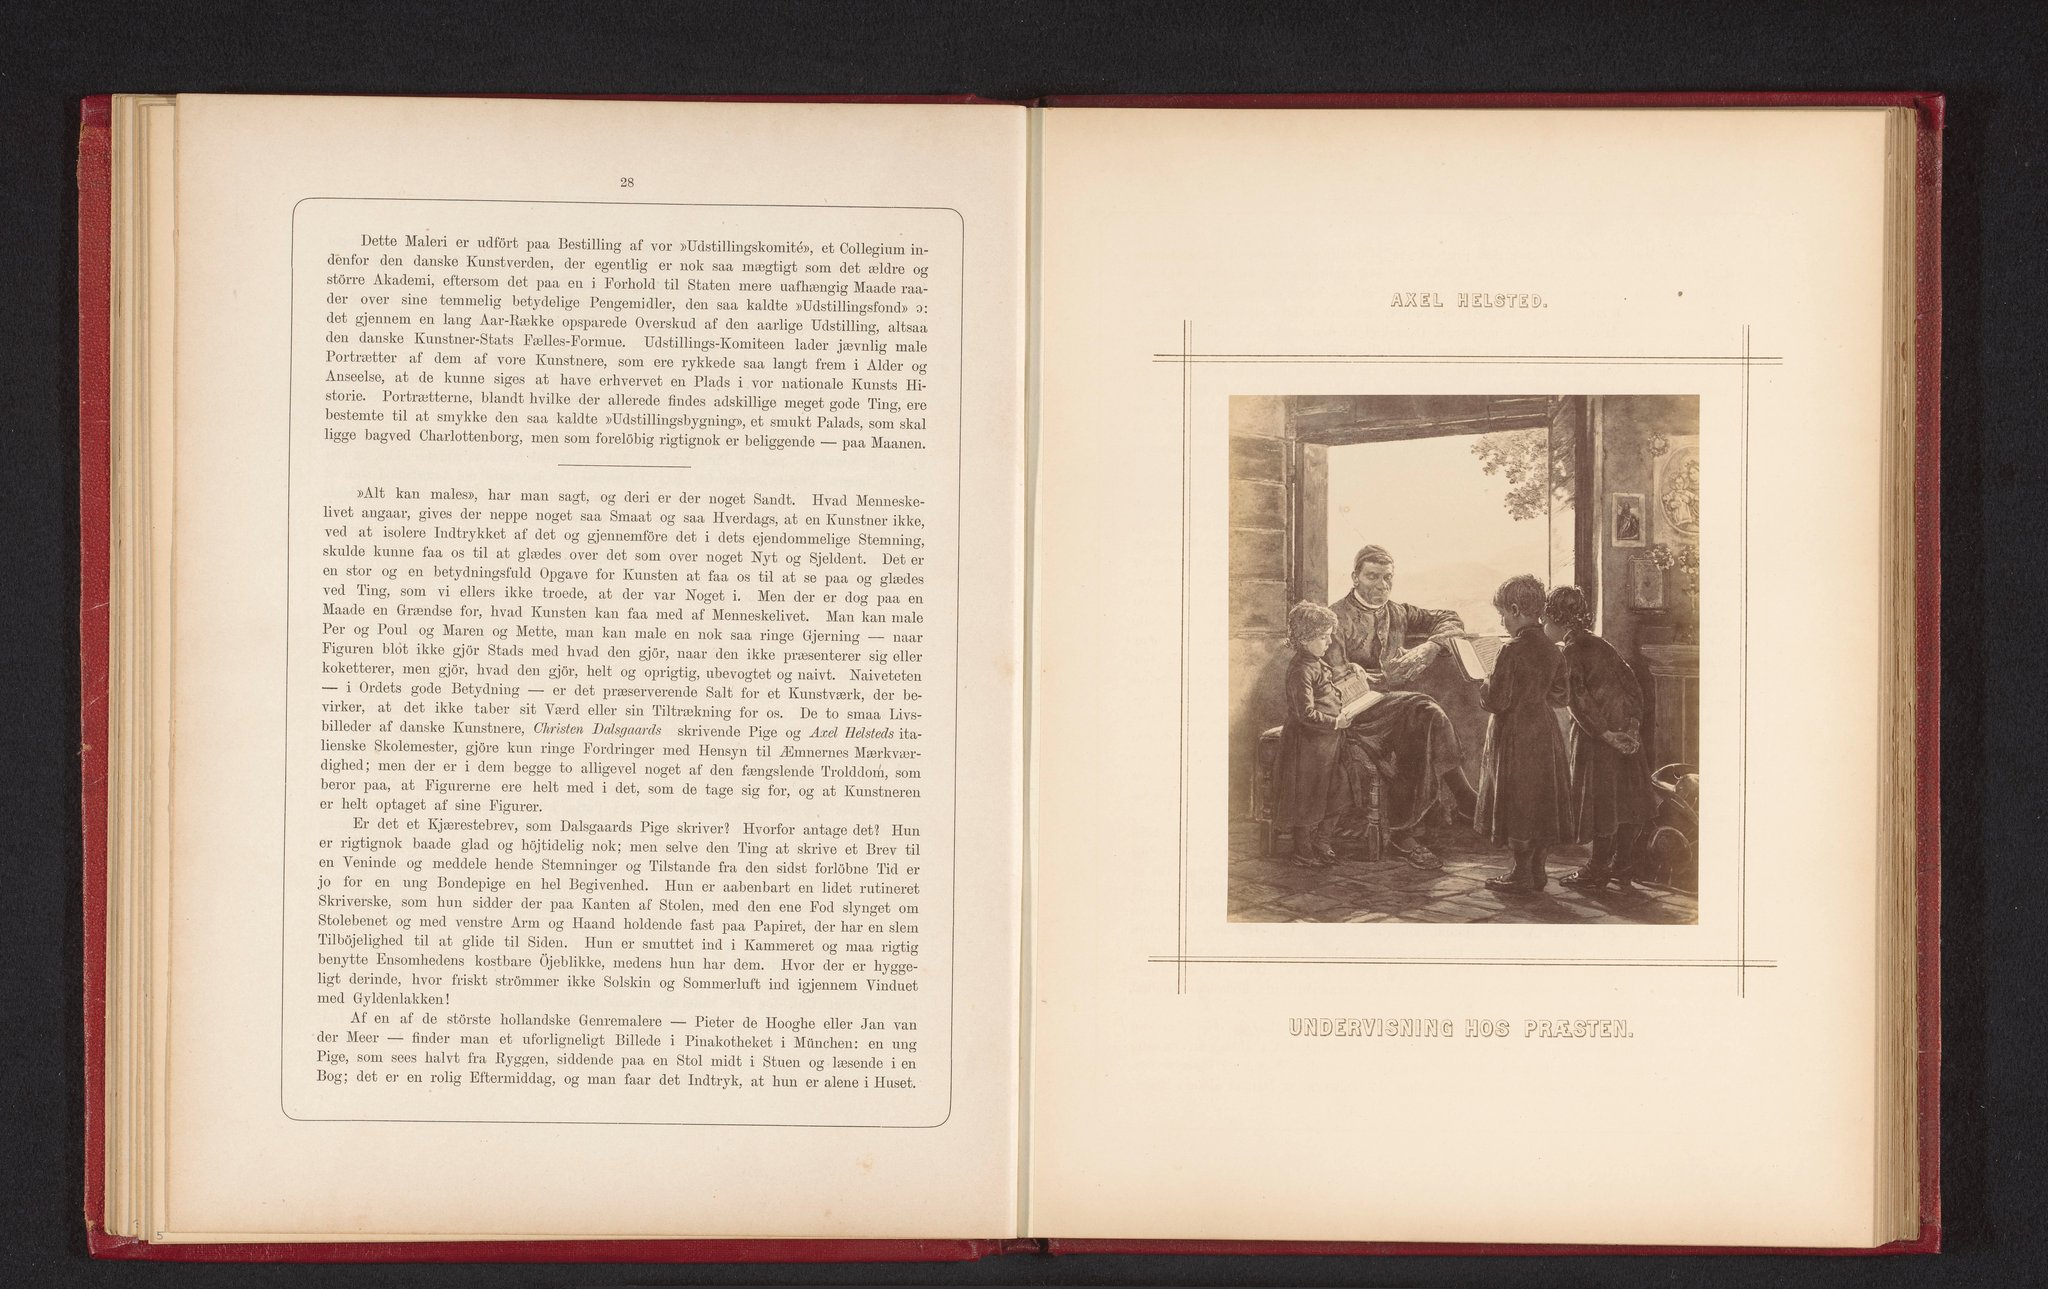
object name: photograph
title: Undervisning Hos Præsten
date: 1874-1879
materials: photographic support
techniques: albumen print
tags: theologian, education